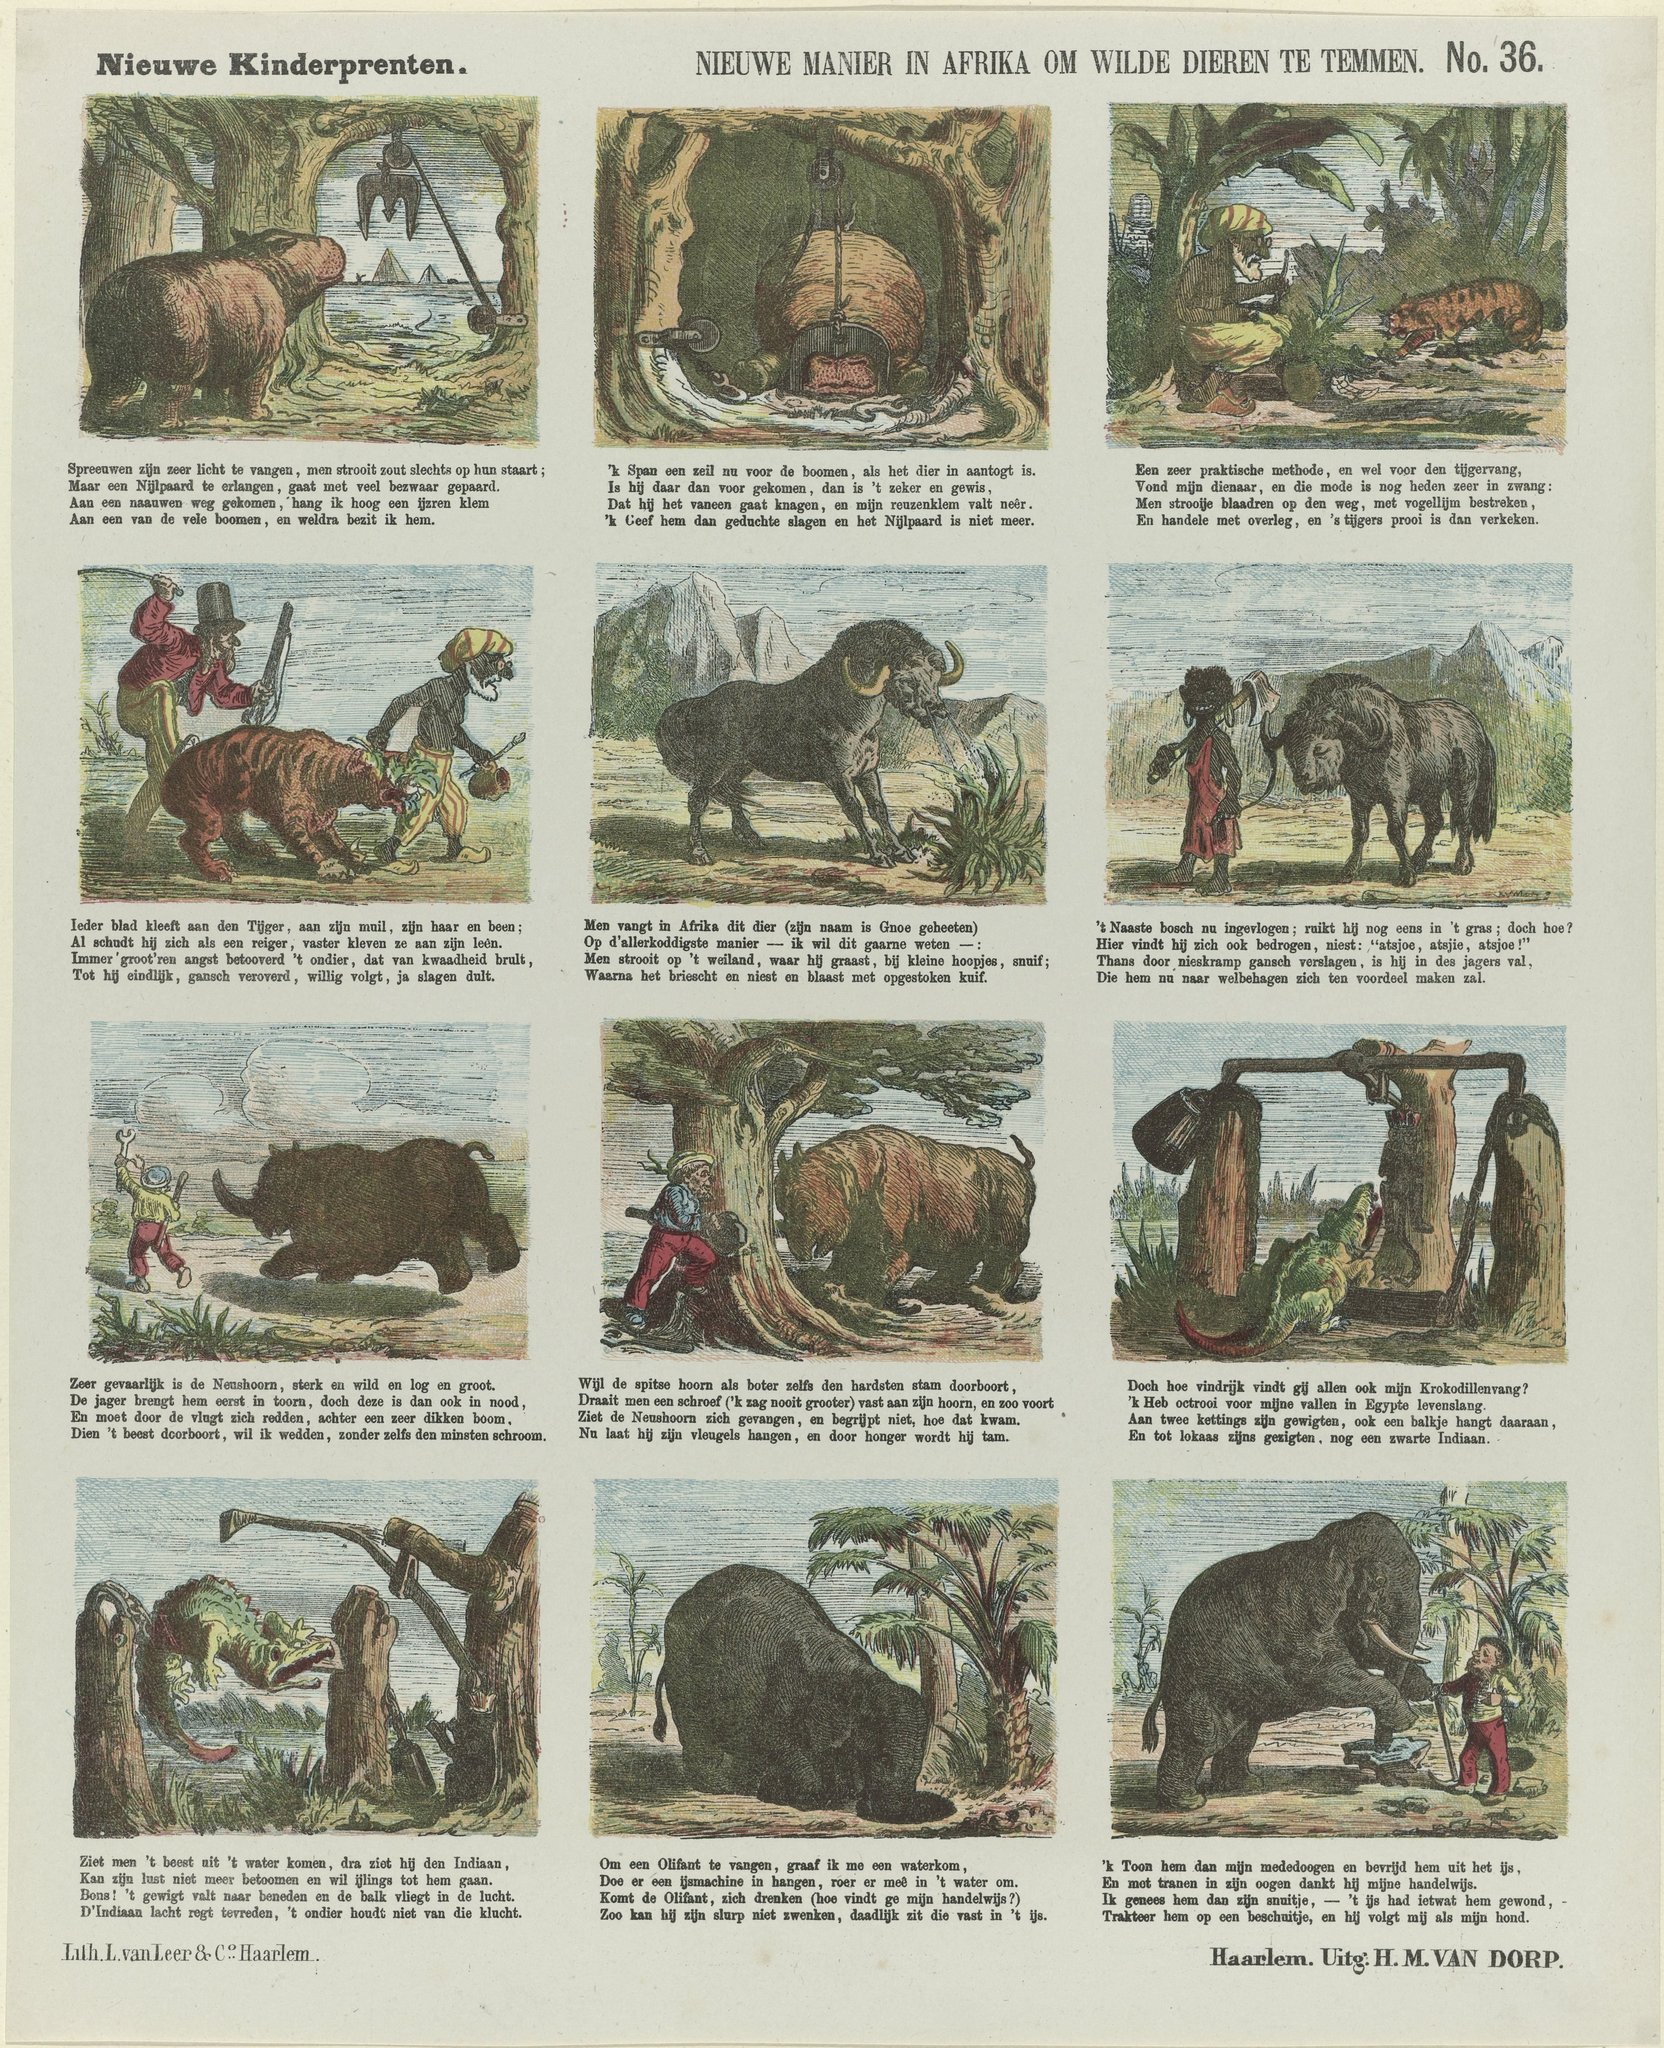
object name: popular print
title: Nieuwe kinderprenten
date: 1872-1883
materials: paper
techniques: lithograph, letterpress printing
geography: haarlem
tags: taming and training of animals, animals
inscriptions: collector's mark: Lugt 2760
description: Blad met 12 voorstellingen over het temmen van wilde dieren in Afrika. Onder elke afbeelding een vierregelig vers. Genummerd rechtsboven: No. 36.